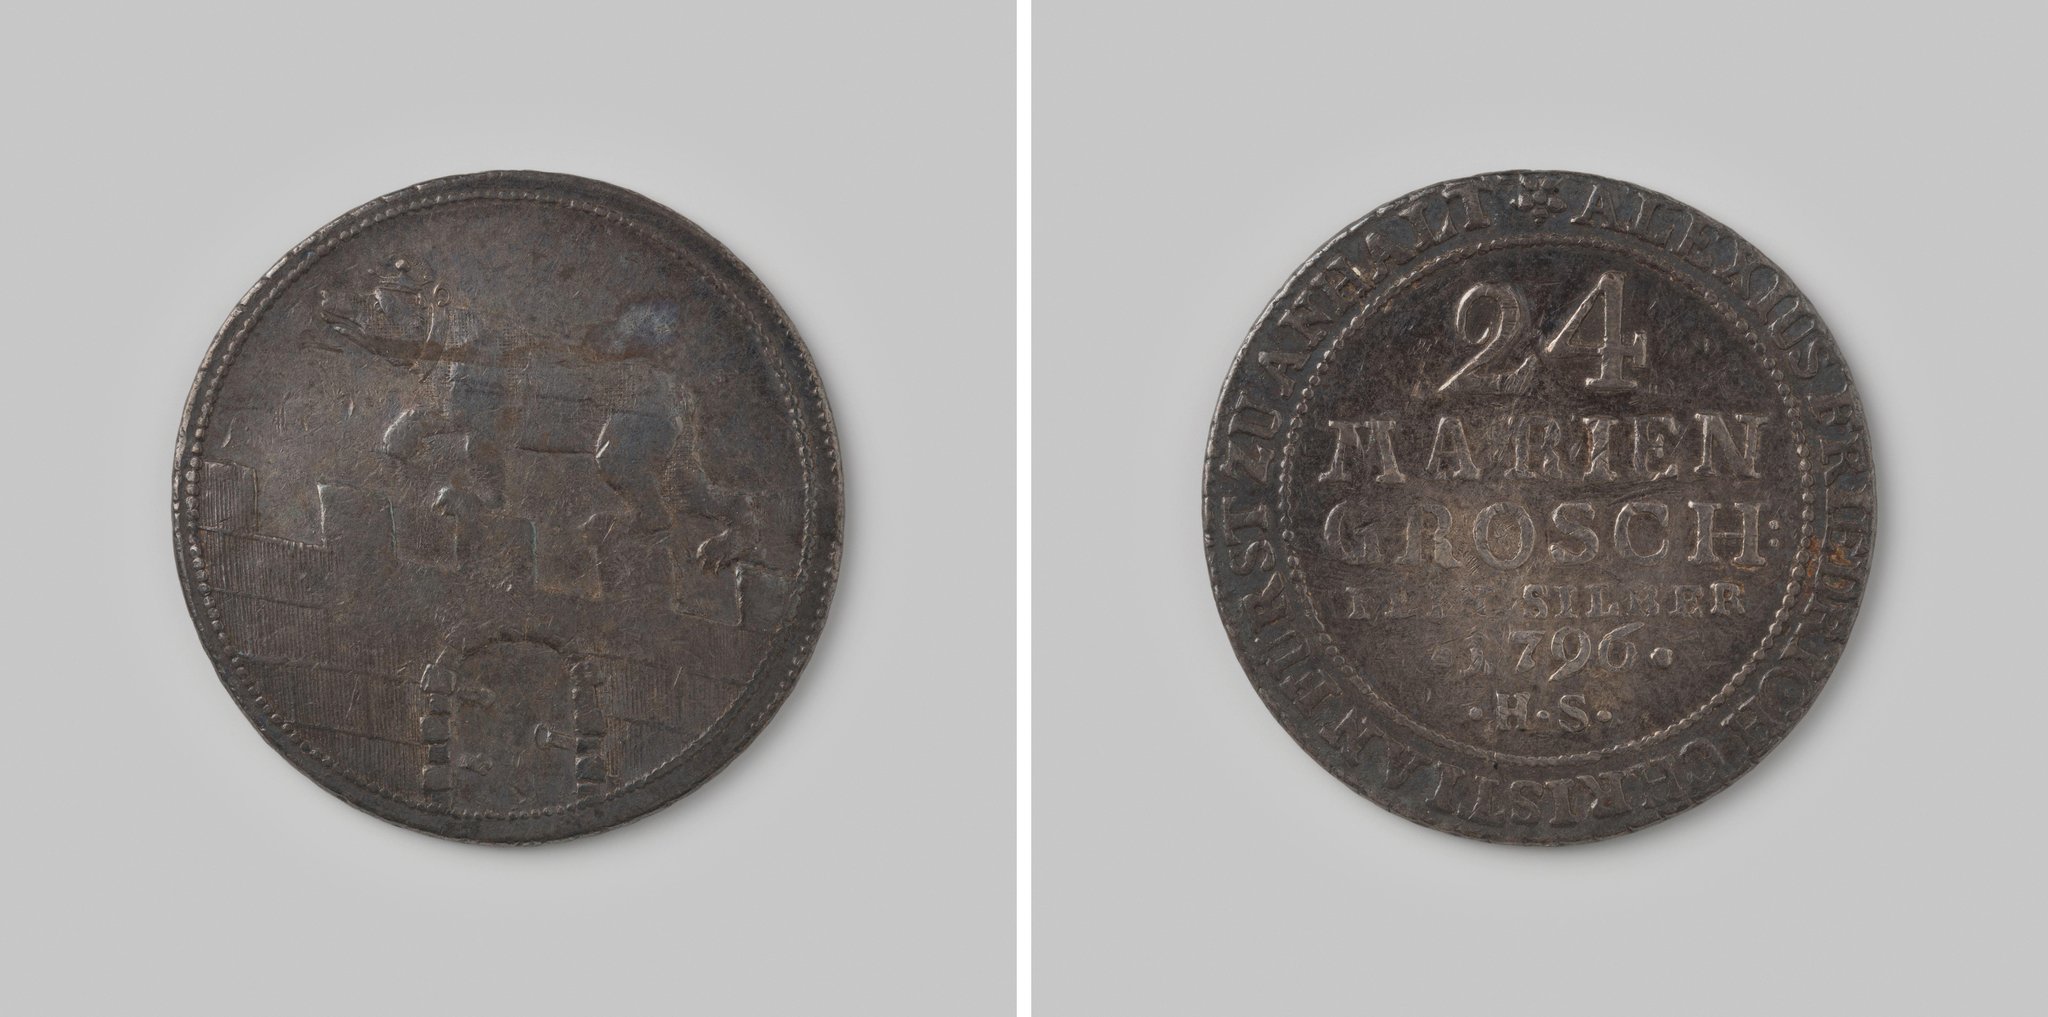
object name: coin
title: Vorstendom Anhalt-Bernburg, Alexius Friedrich Christian, 24 Mariengroschen, 1796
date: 1796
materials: silver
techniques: striking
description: Zilveren munt. Voorzijde: gekroonde beer met halsband, naar links lopend op stadsmuur met poort. Keerzijde: waarde-aanduiding in vier regels, waaronder jaartal. Kartelrand.